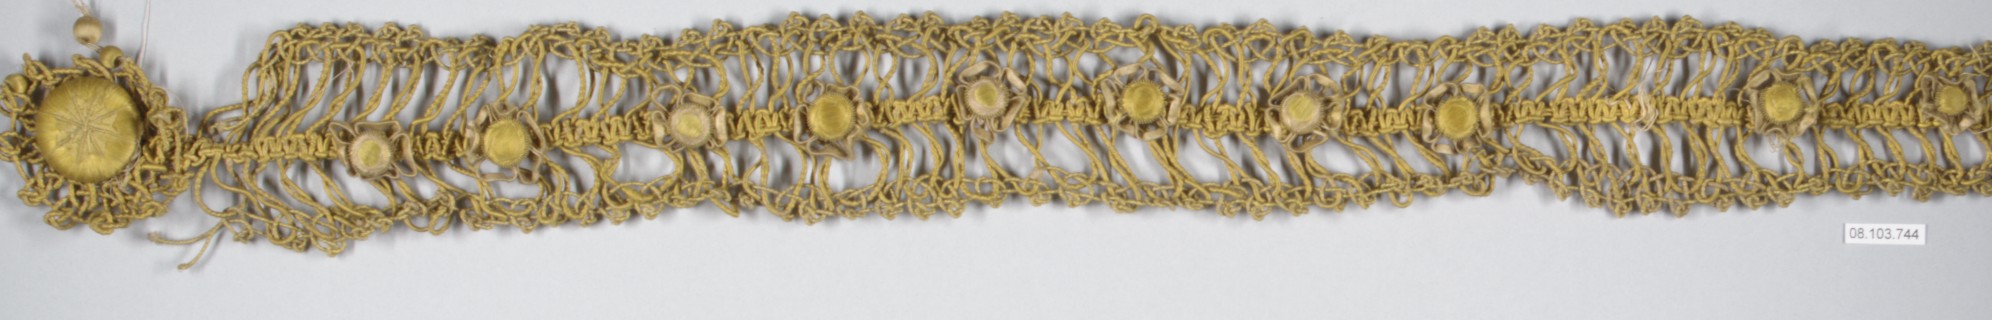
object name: gimp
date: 1801-1900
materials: silk